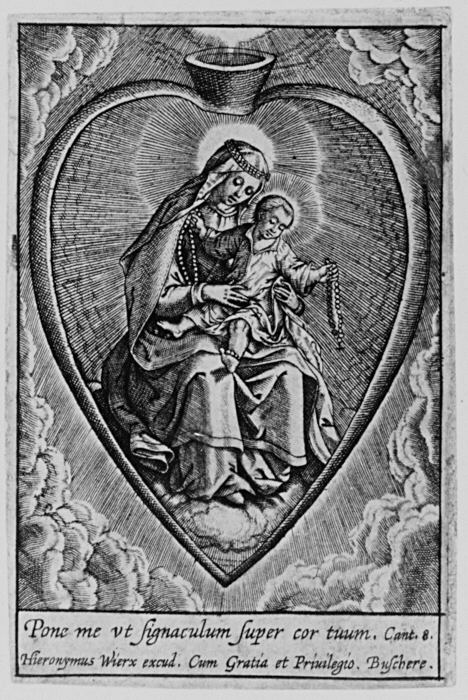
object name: print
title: Virgin and Child in a Heart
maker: hieronymus wierix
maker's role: artist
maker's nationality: netherlandish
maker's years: 1553-1619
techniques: engraving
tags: madonna and child